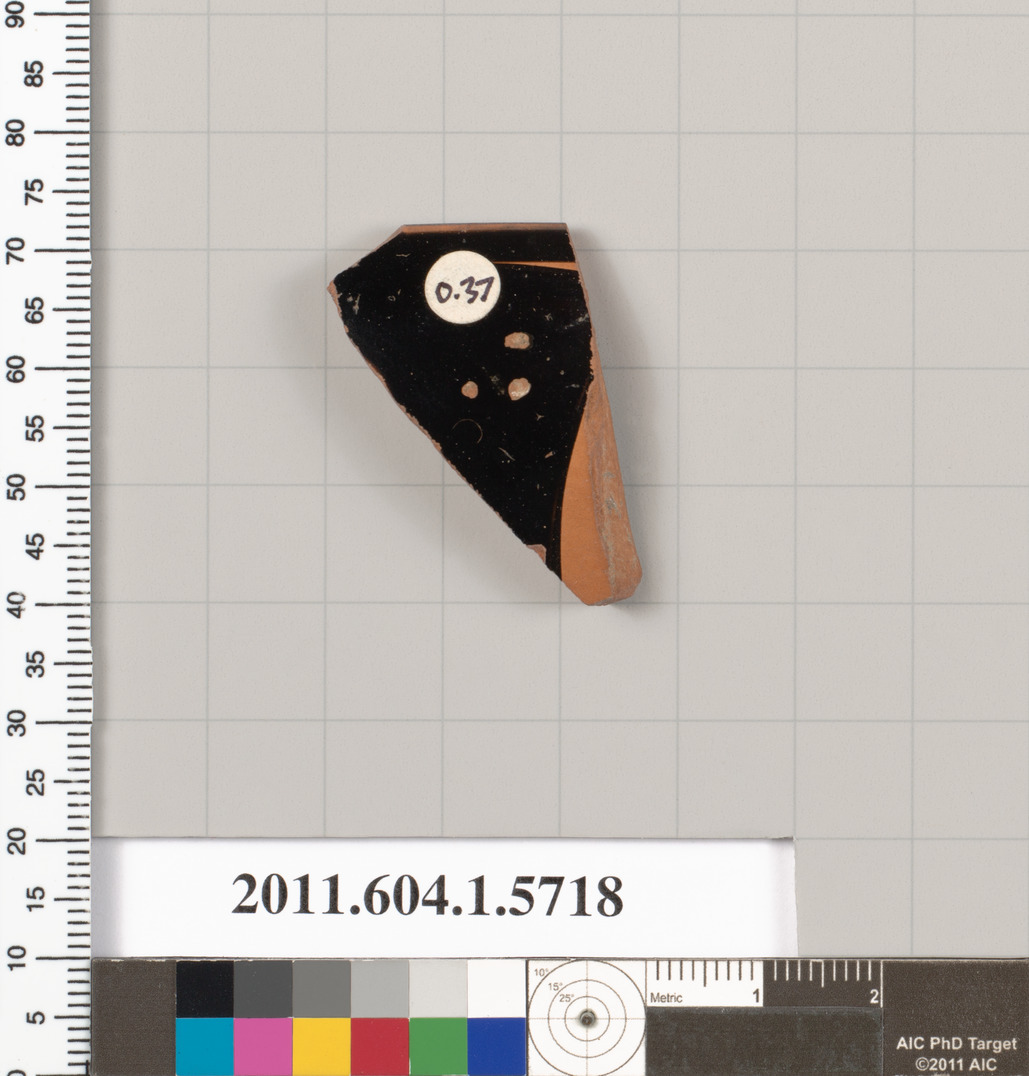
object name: kylix fragment, eye cup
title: Terracotta rim fragment of a kylix: eye-cup (drinking cup)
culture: greek, attic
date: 520-490 BCE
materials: terracotta